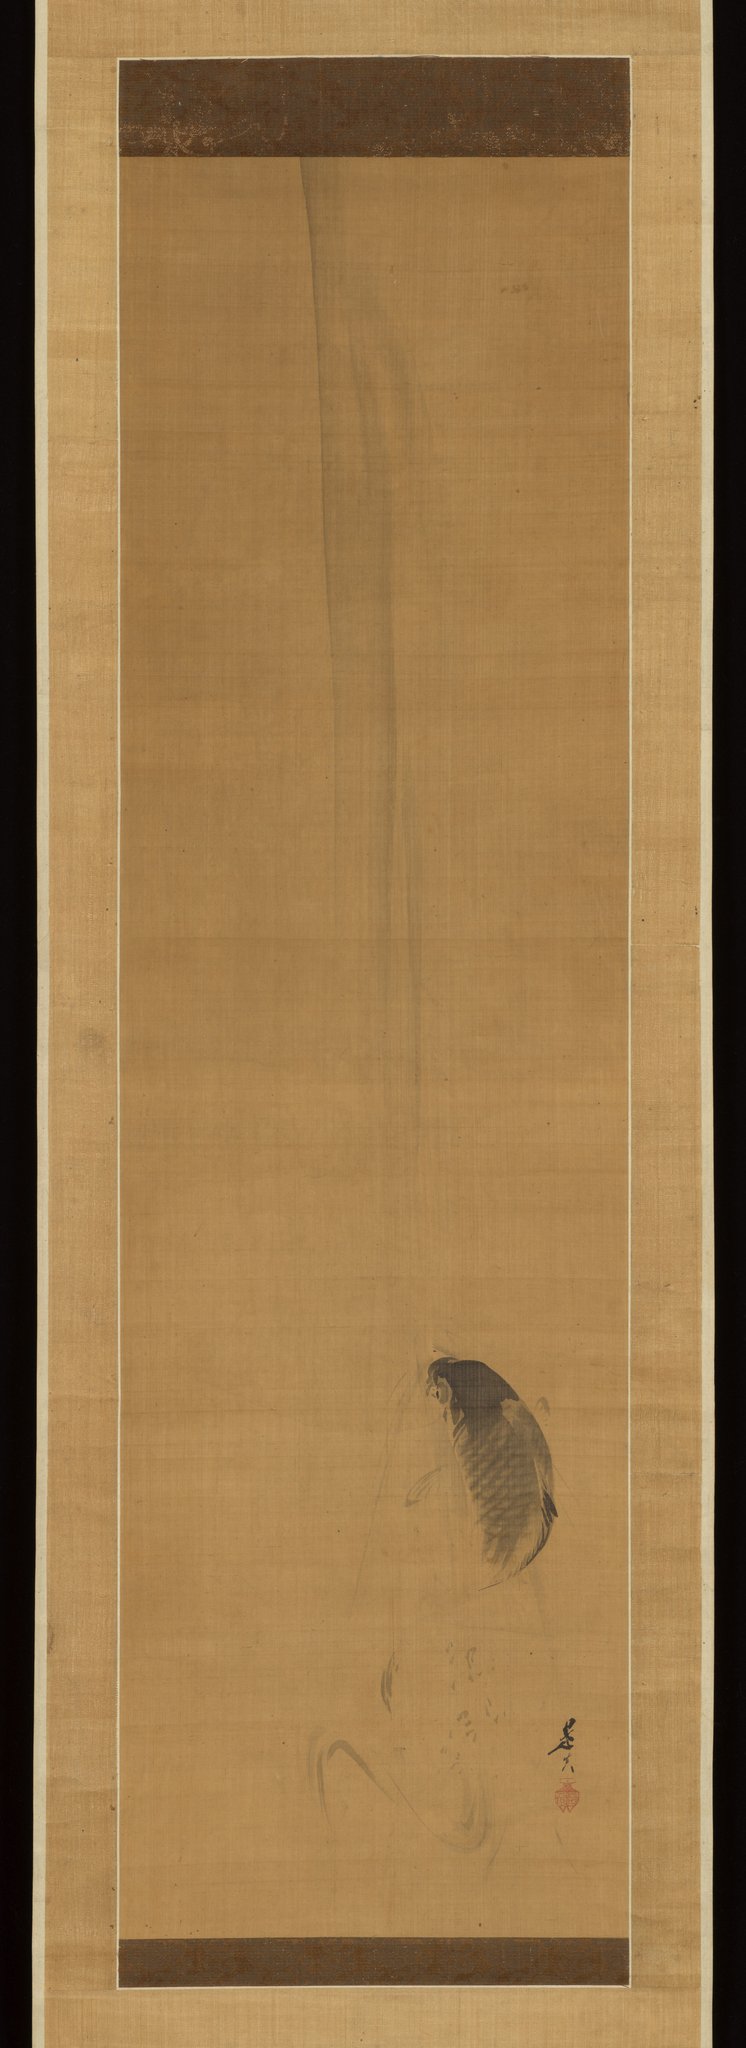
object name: hanging scroll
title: Carp Ascending Waterfall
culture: japanese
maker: shibata zeshin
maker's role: artist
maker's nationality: japanese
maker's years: 1807-1891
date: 1801-1900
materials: ink, silk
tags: fish,waterfalls